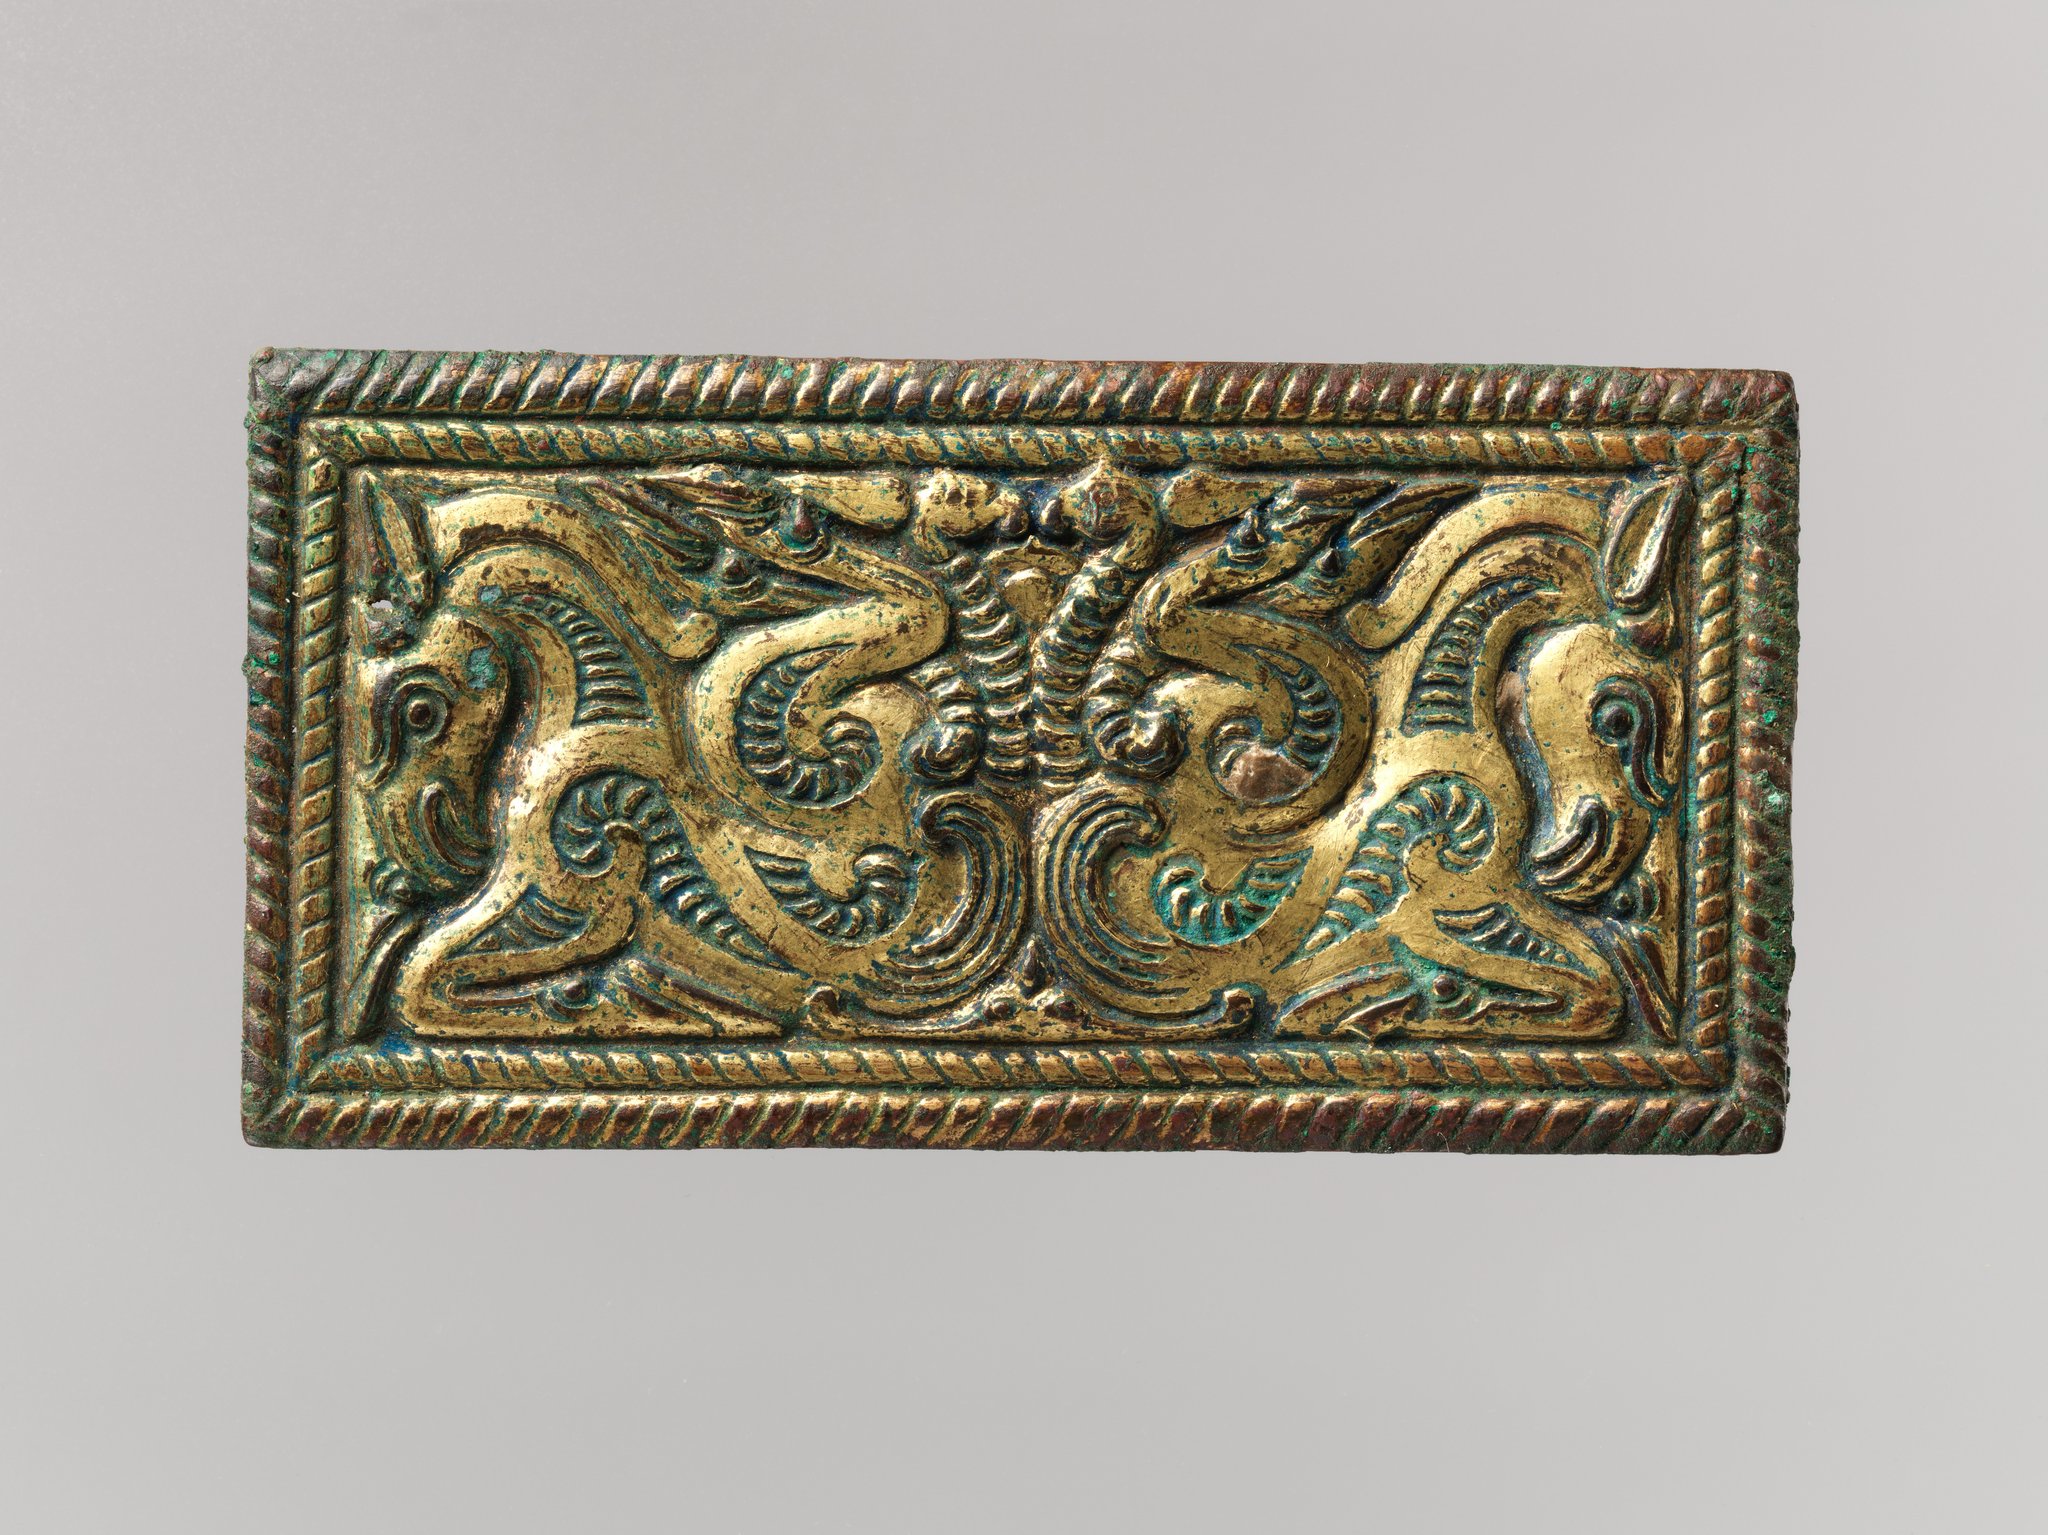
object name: belt buckle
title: Belt Buckle with Beaked Ungulates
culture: north chinese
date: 200-101 BCE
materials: bronze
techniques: gilding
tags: animals